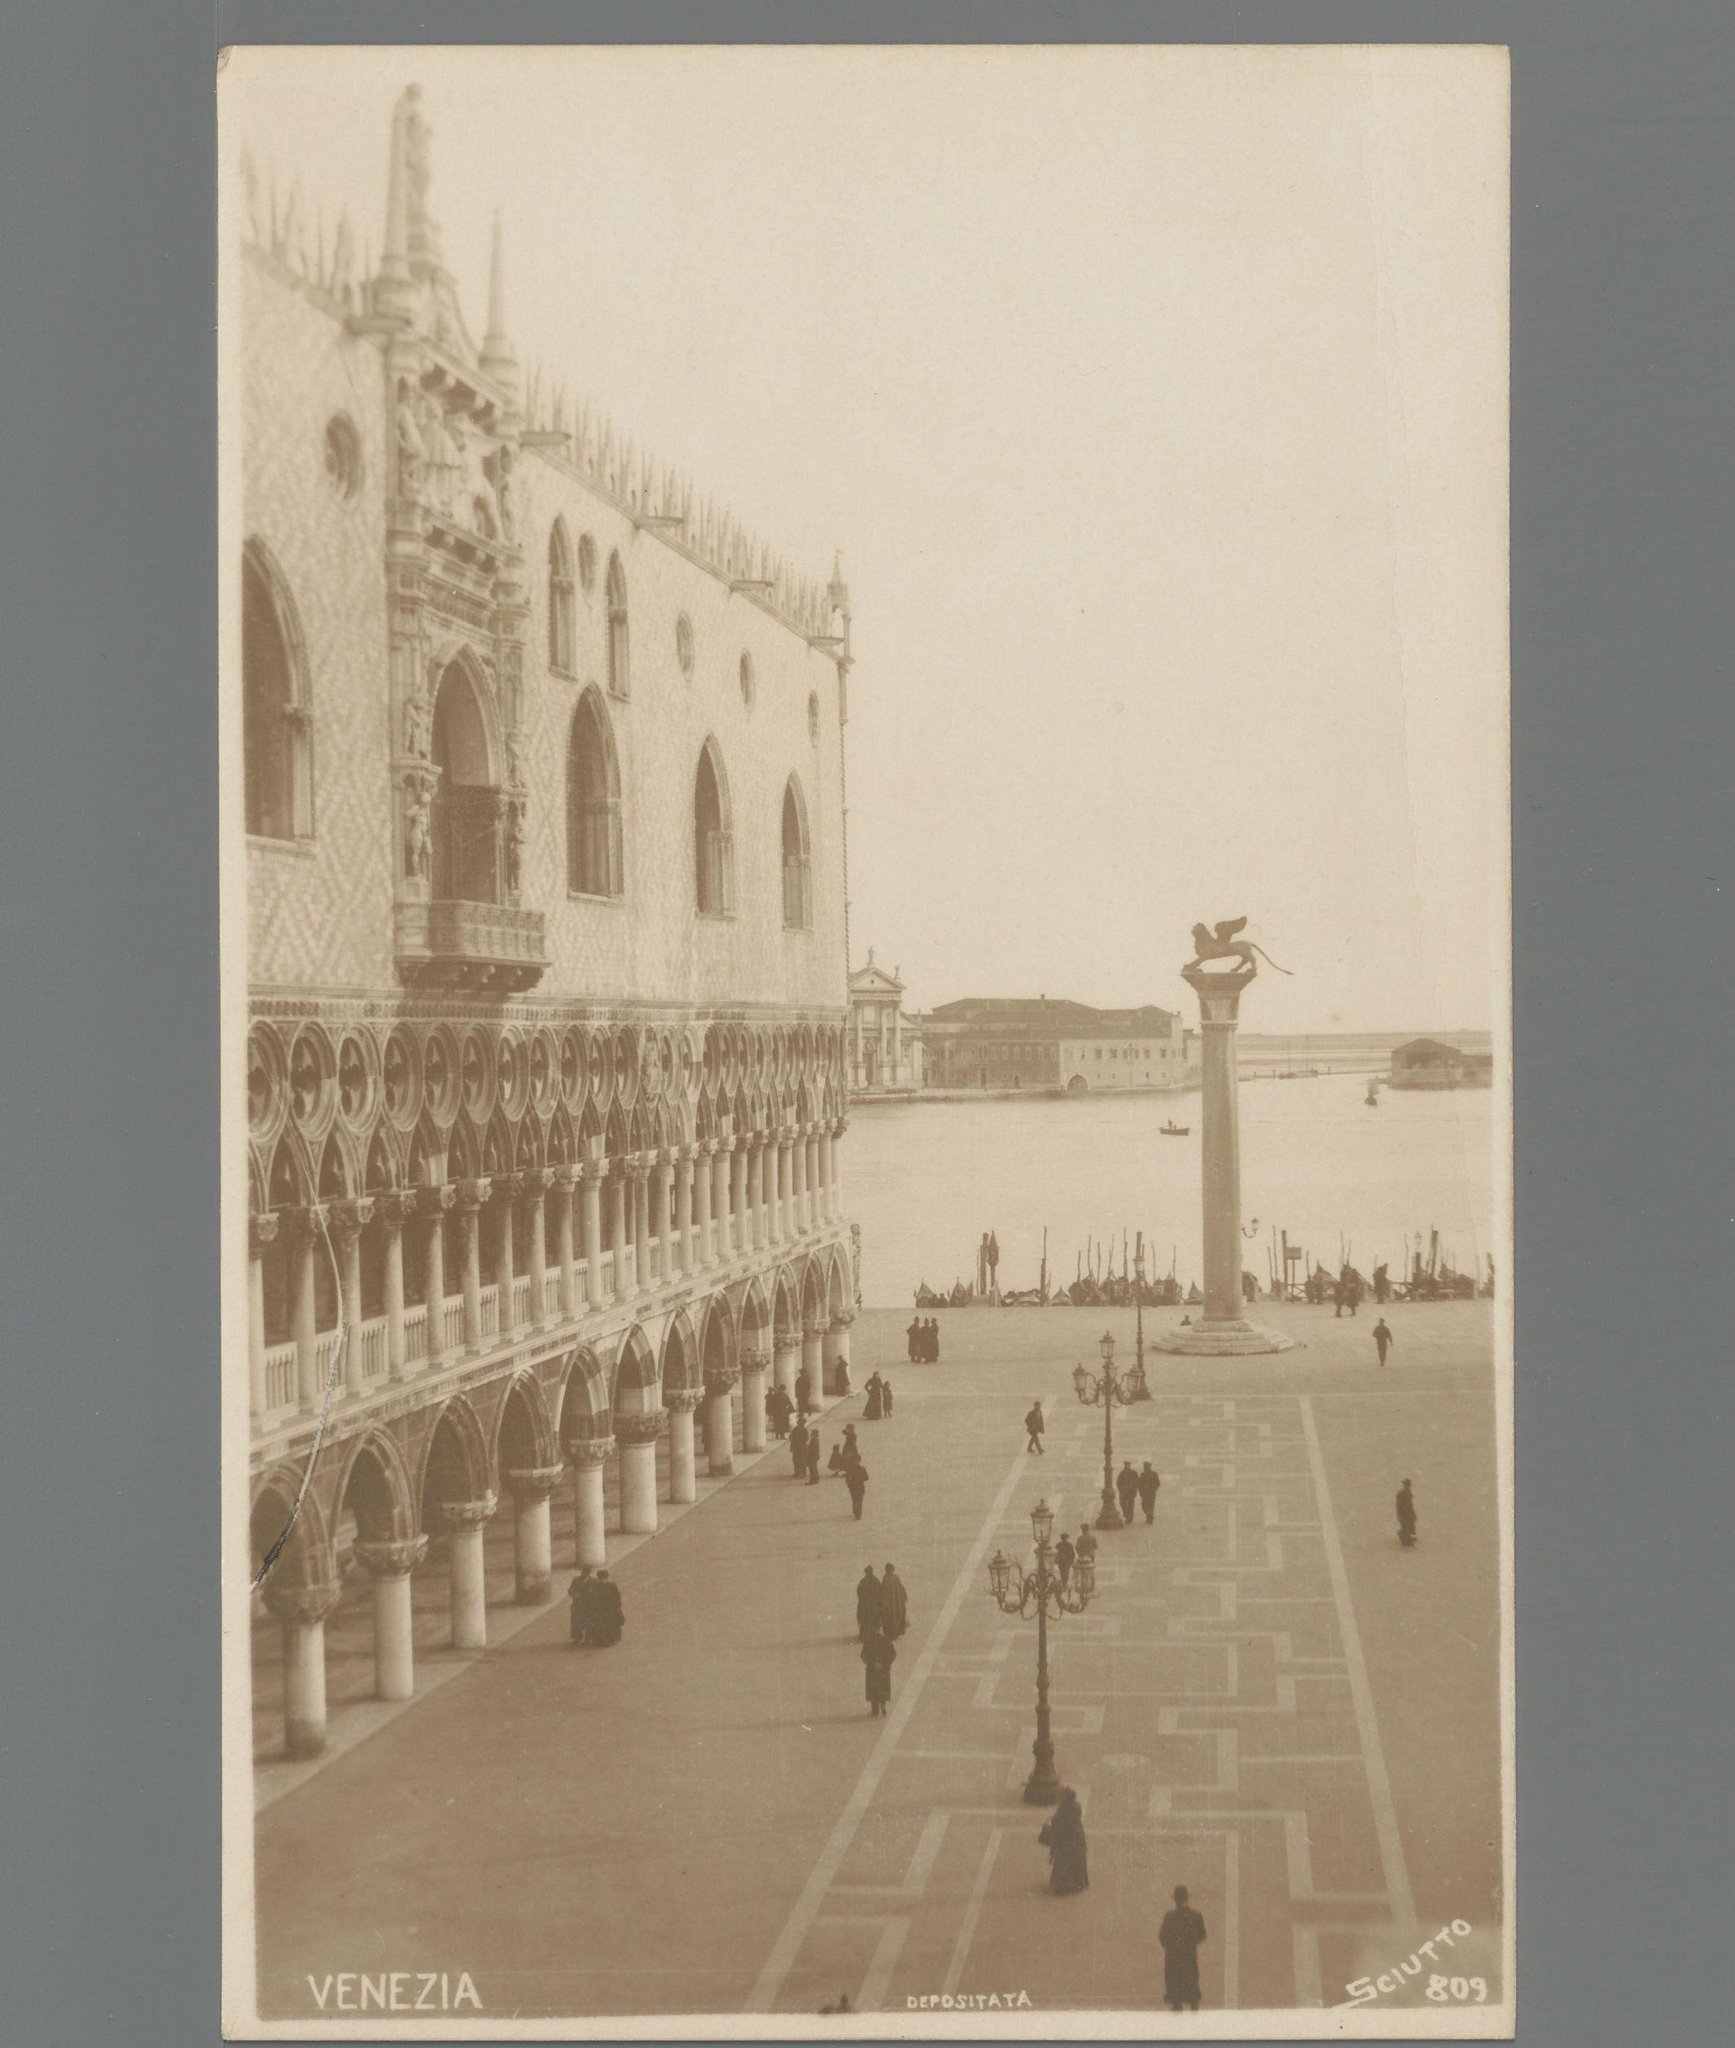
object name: photograph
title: Venezia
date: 1906-1920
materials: photographic support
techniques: photography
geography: venice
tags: palace, square, place, circus, etc. (+ city(-scape) with figures, staffage)